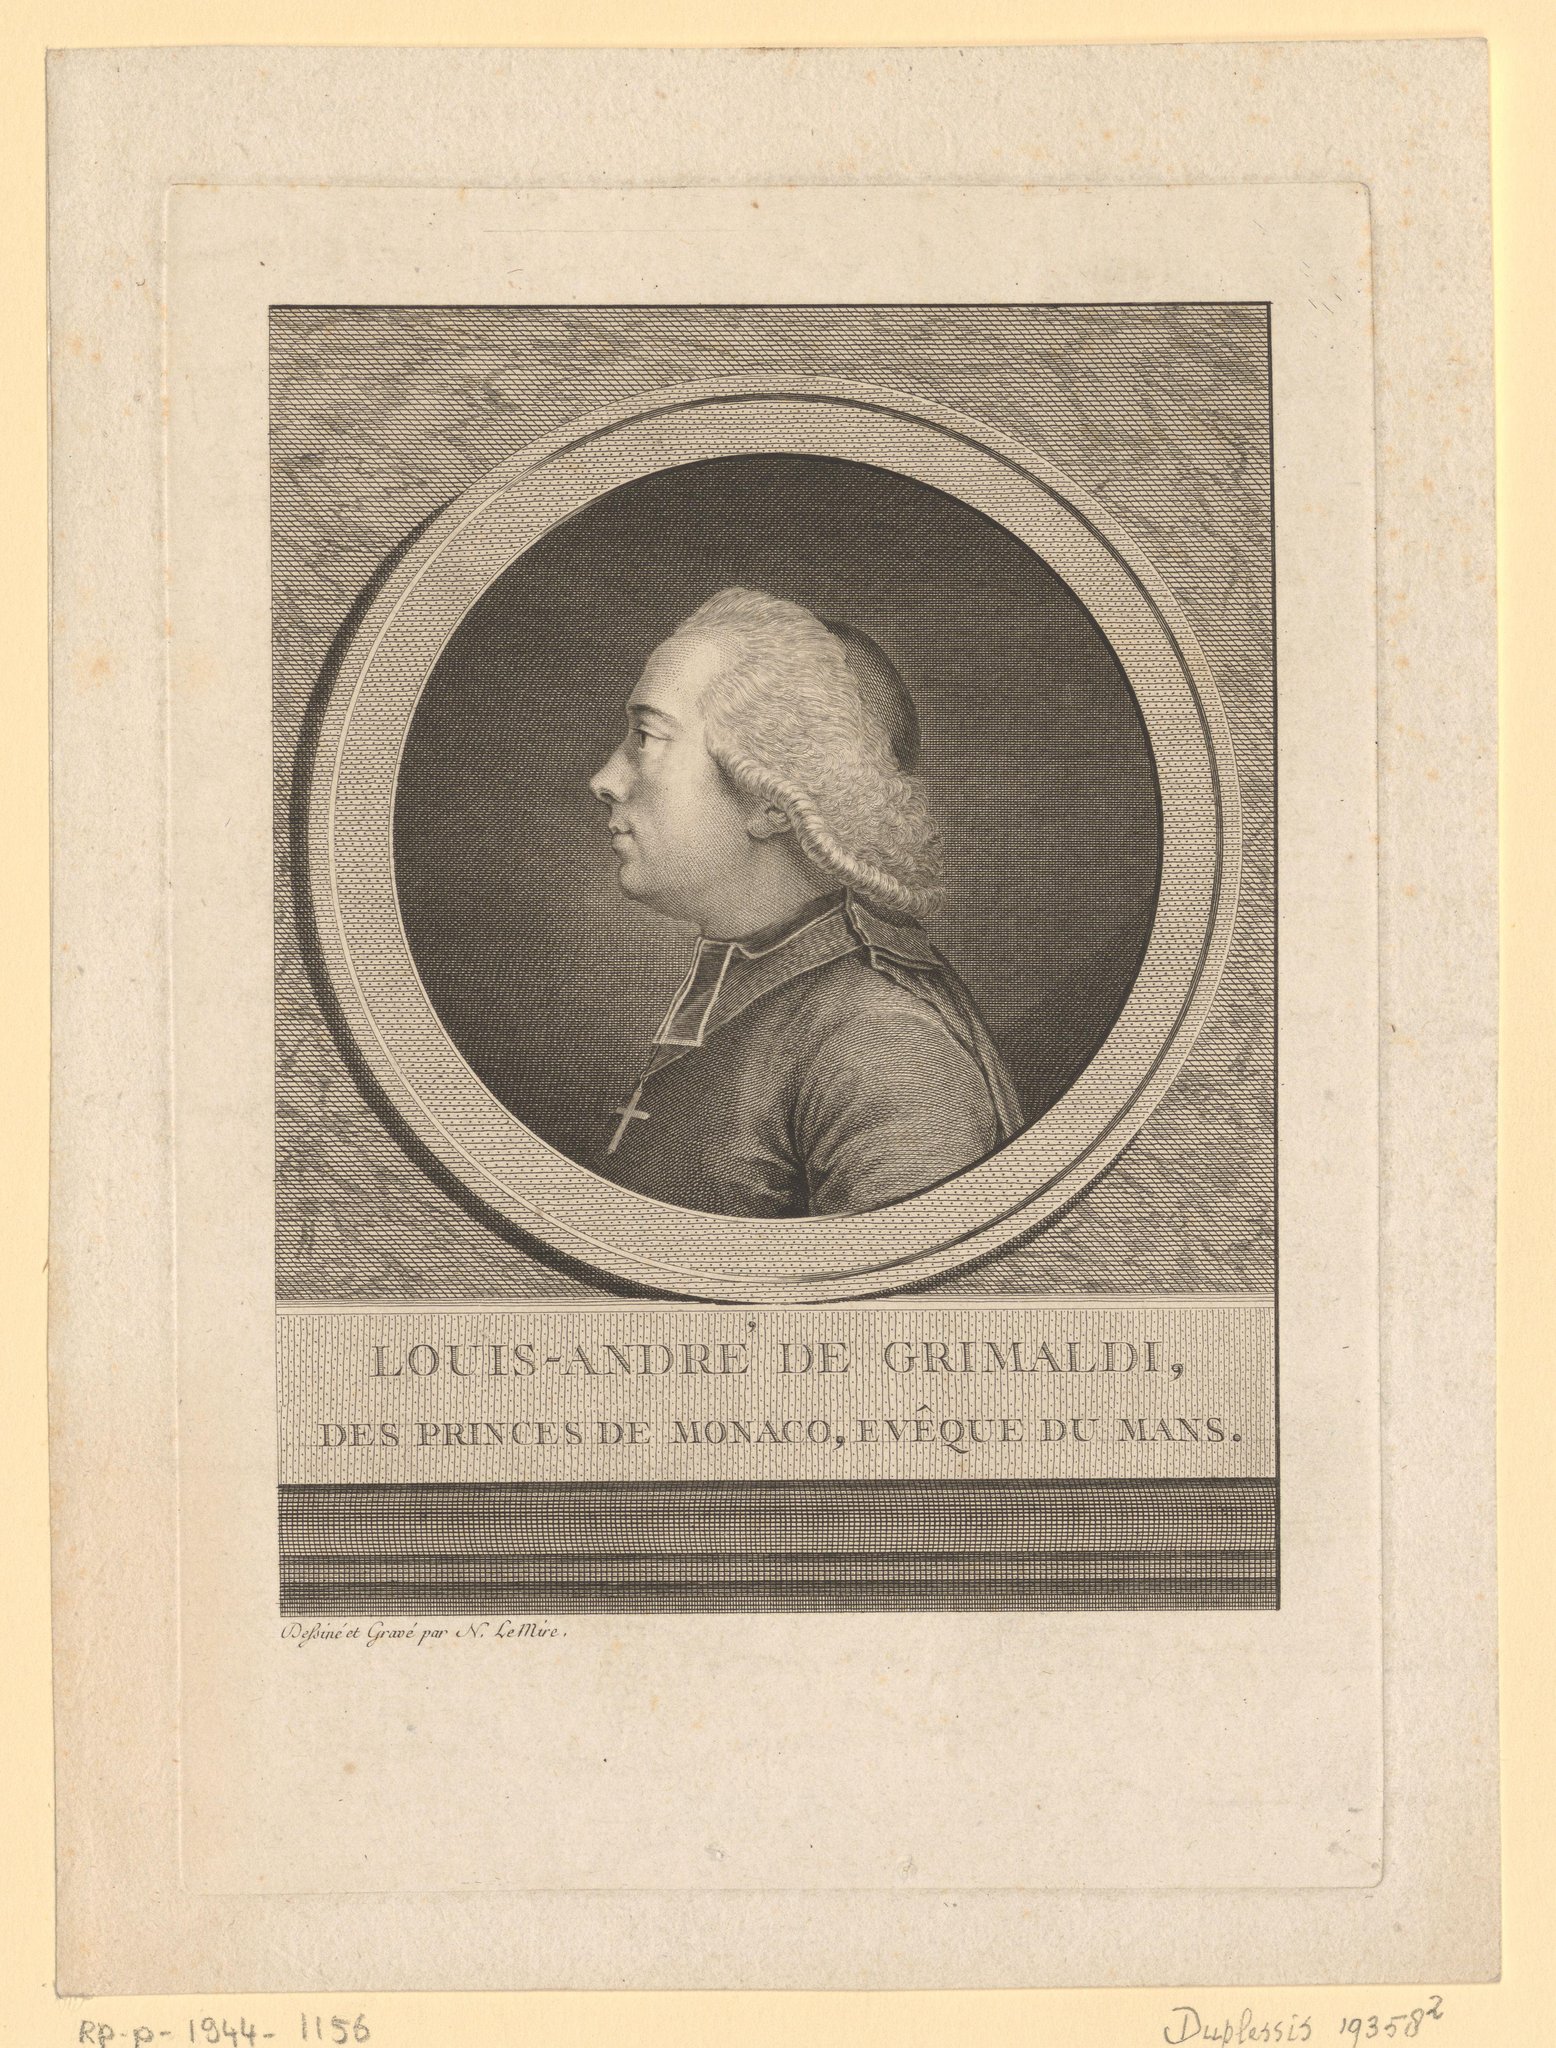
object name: print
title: Portret van Louis-André de Grimaldi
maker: noël le mire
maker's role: print maker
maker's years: 1724-1801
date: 1734-1801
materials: paper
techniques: engraving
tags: louis-andré de grimaldi, historical persons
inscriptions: collector's mark: Lugt 2228